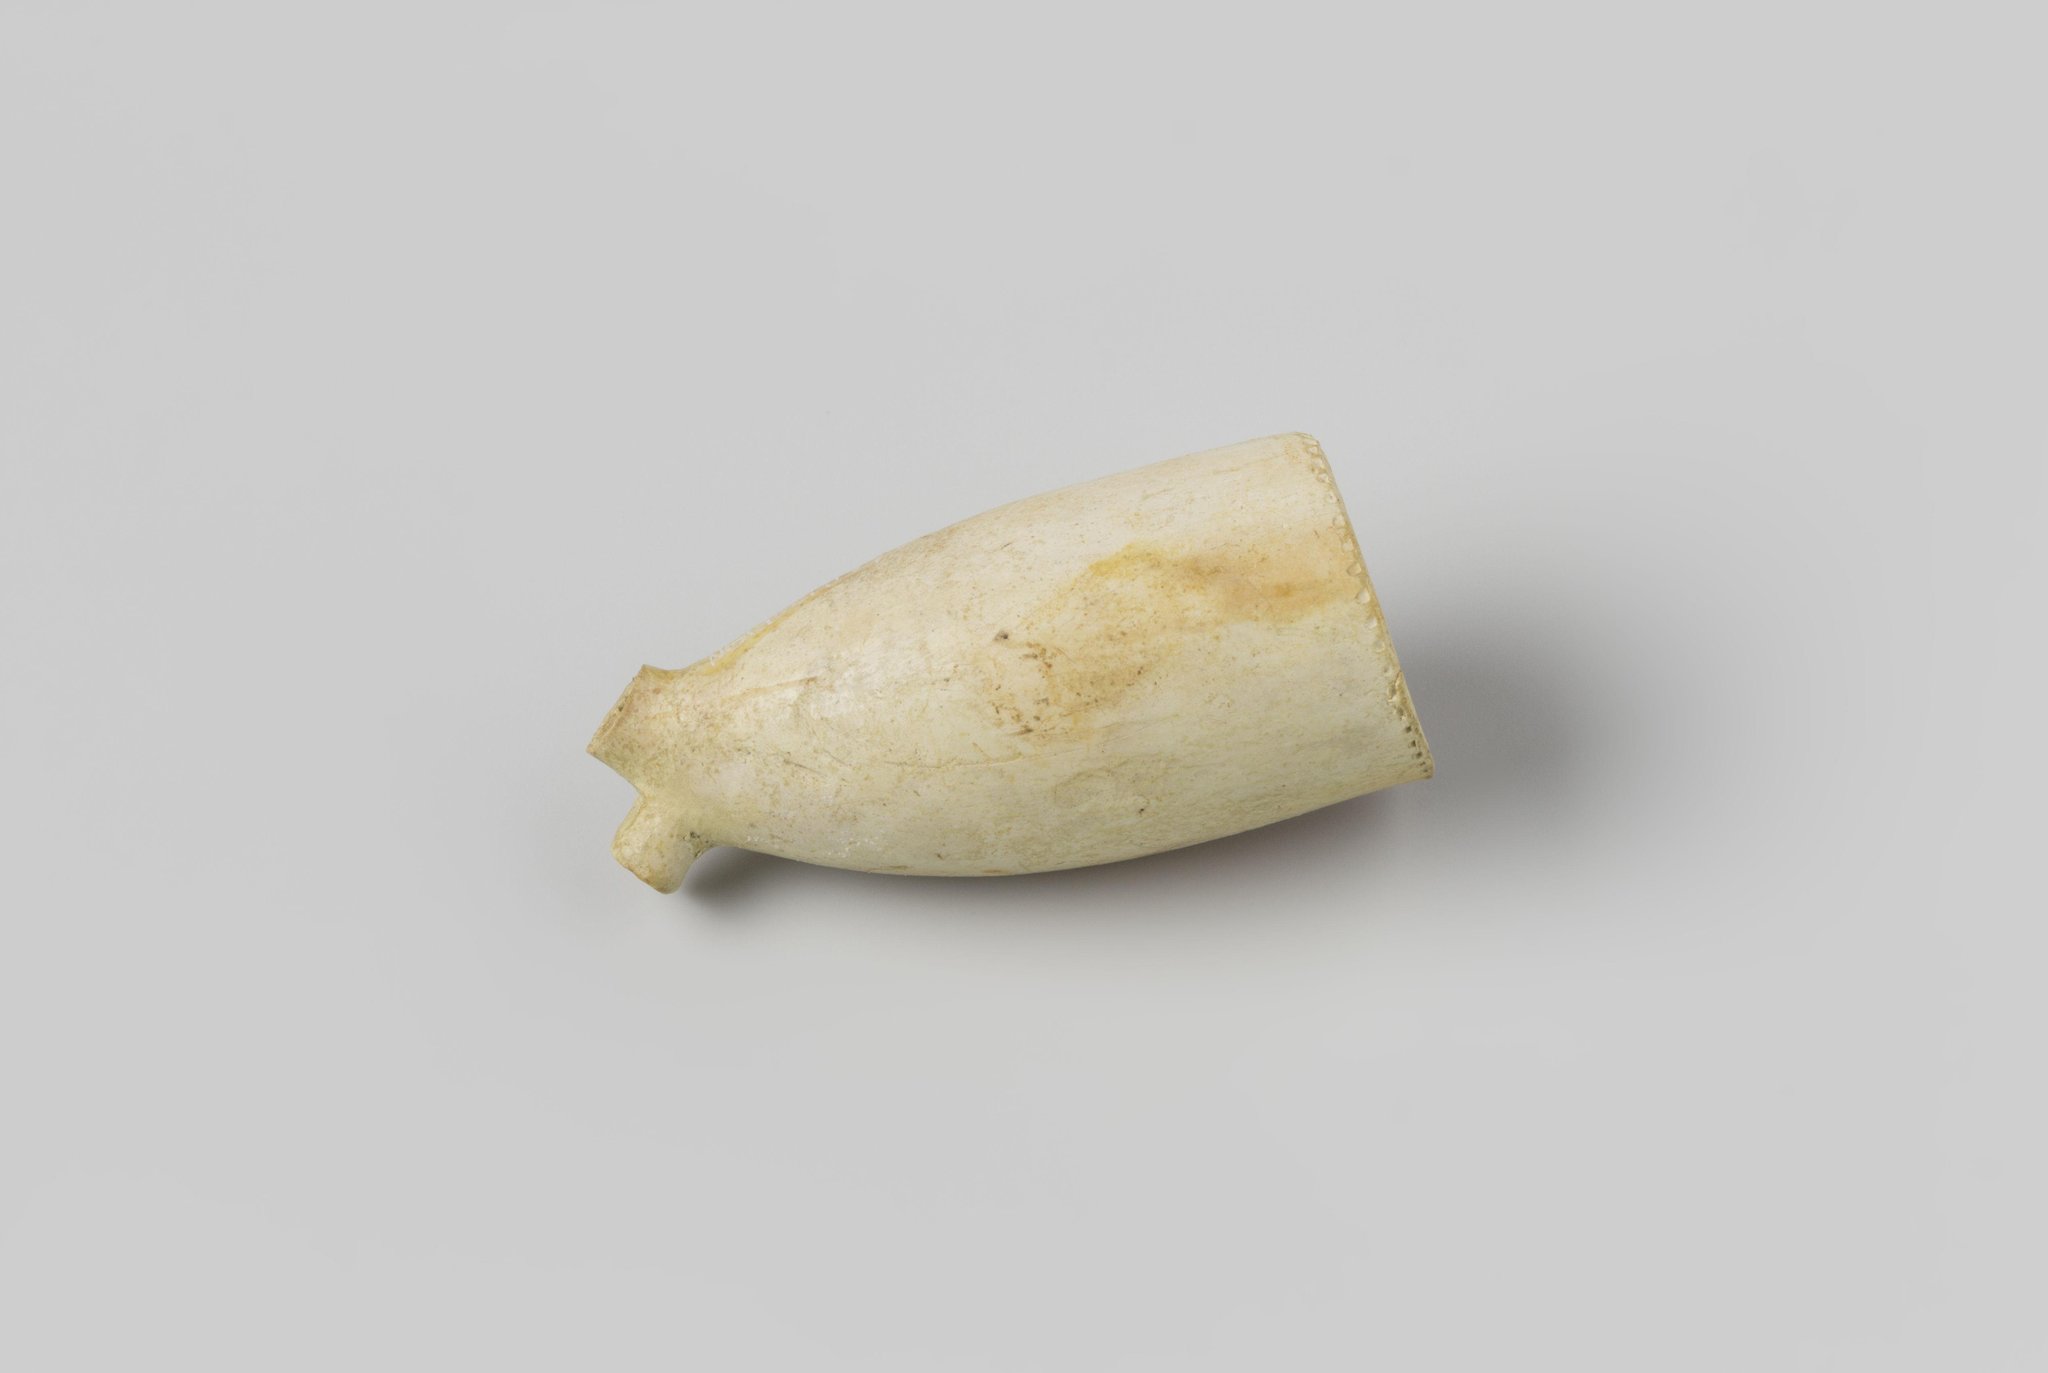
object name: pipe bowl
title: Pijpenkop uit het wrak van de Oost-Indiëvaarder Hollandia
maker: Anonymous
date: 1700-1743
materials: clay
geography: netherlands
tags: verenigde oostindische compagnie, hollandia (schip), annet